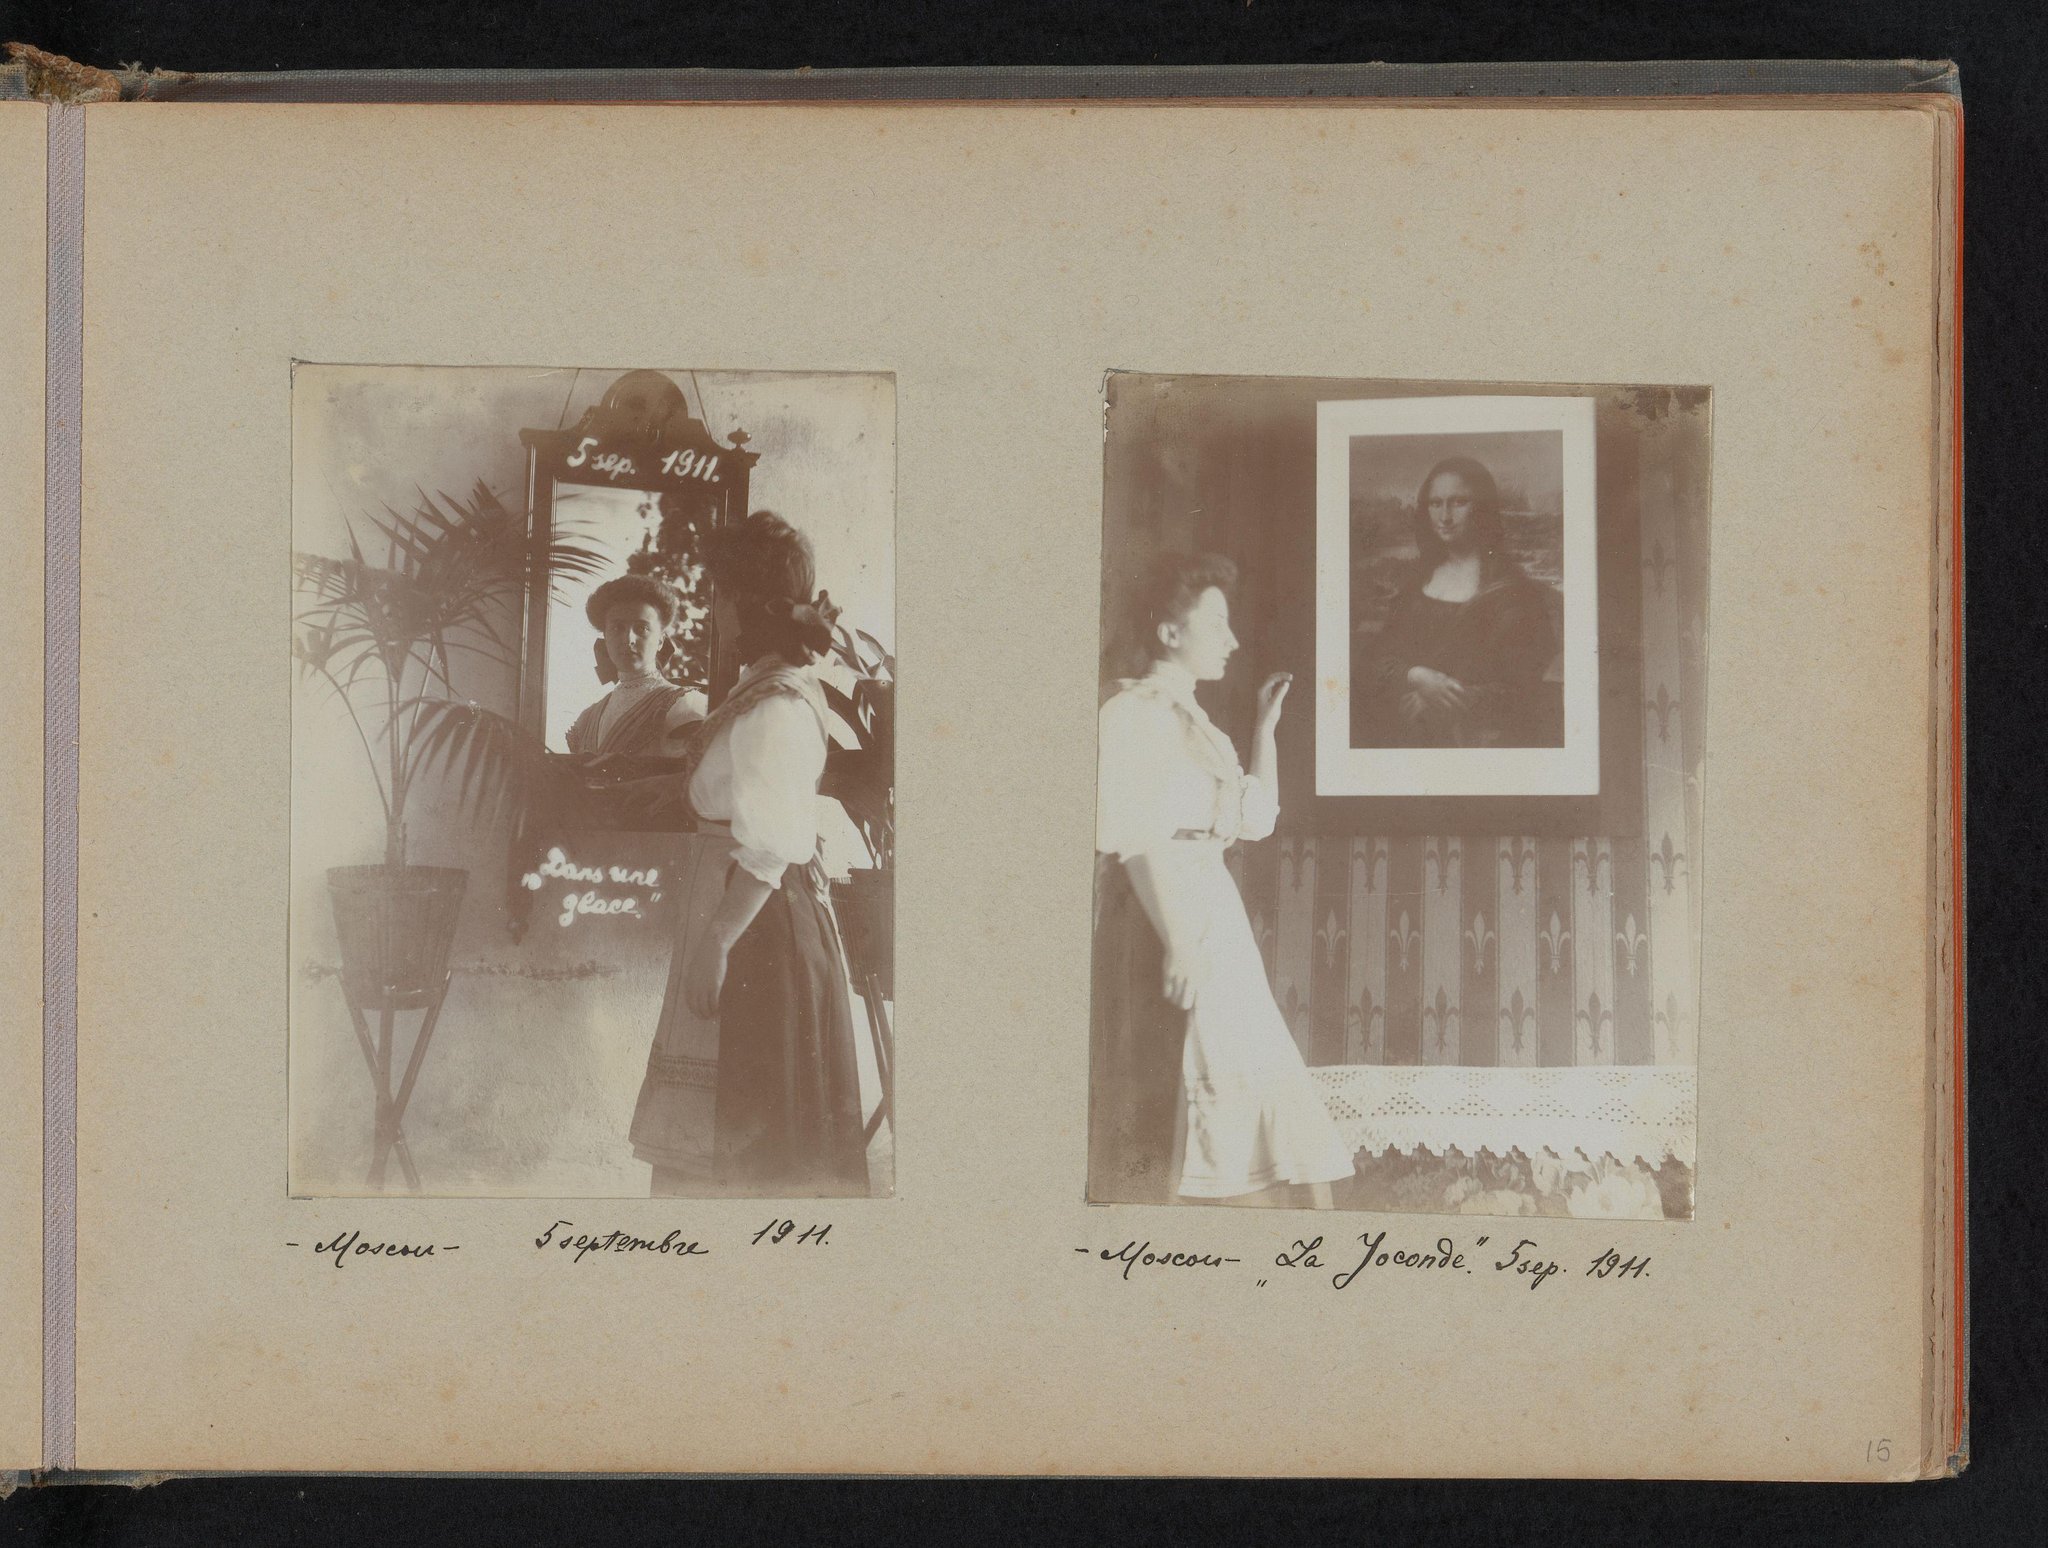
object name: album leaf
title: Zelfportret voor een spiegel en zelfportret voor een reproductie van de Mona Lisa door Leonardo Da Vinci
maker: Anonymous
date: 1911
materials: paper, cardboard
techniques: collodion silver print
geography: moscow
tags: picture, painting, portrait, self-portrait of photographer, reflection (in a mirror)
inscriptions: inscription: ‘- Moscou - "La Jaconde." 5 sep. 1911.’, inscription: ‘5 sep. 1911/ "Dans une/ glace"’, inscription: ‘- Moscou - 5 septembre 1911.’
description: Deze foto's maken deel uit van een album.